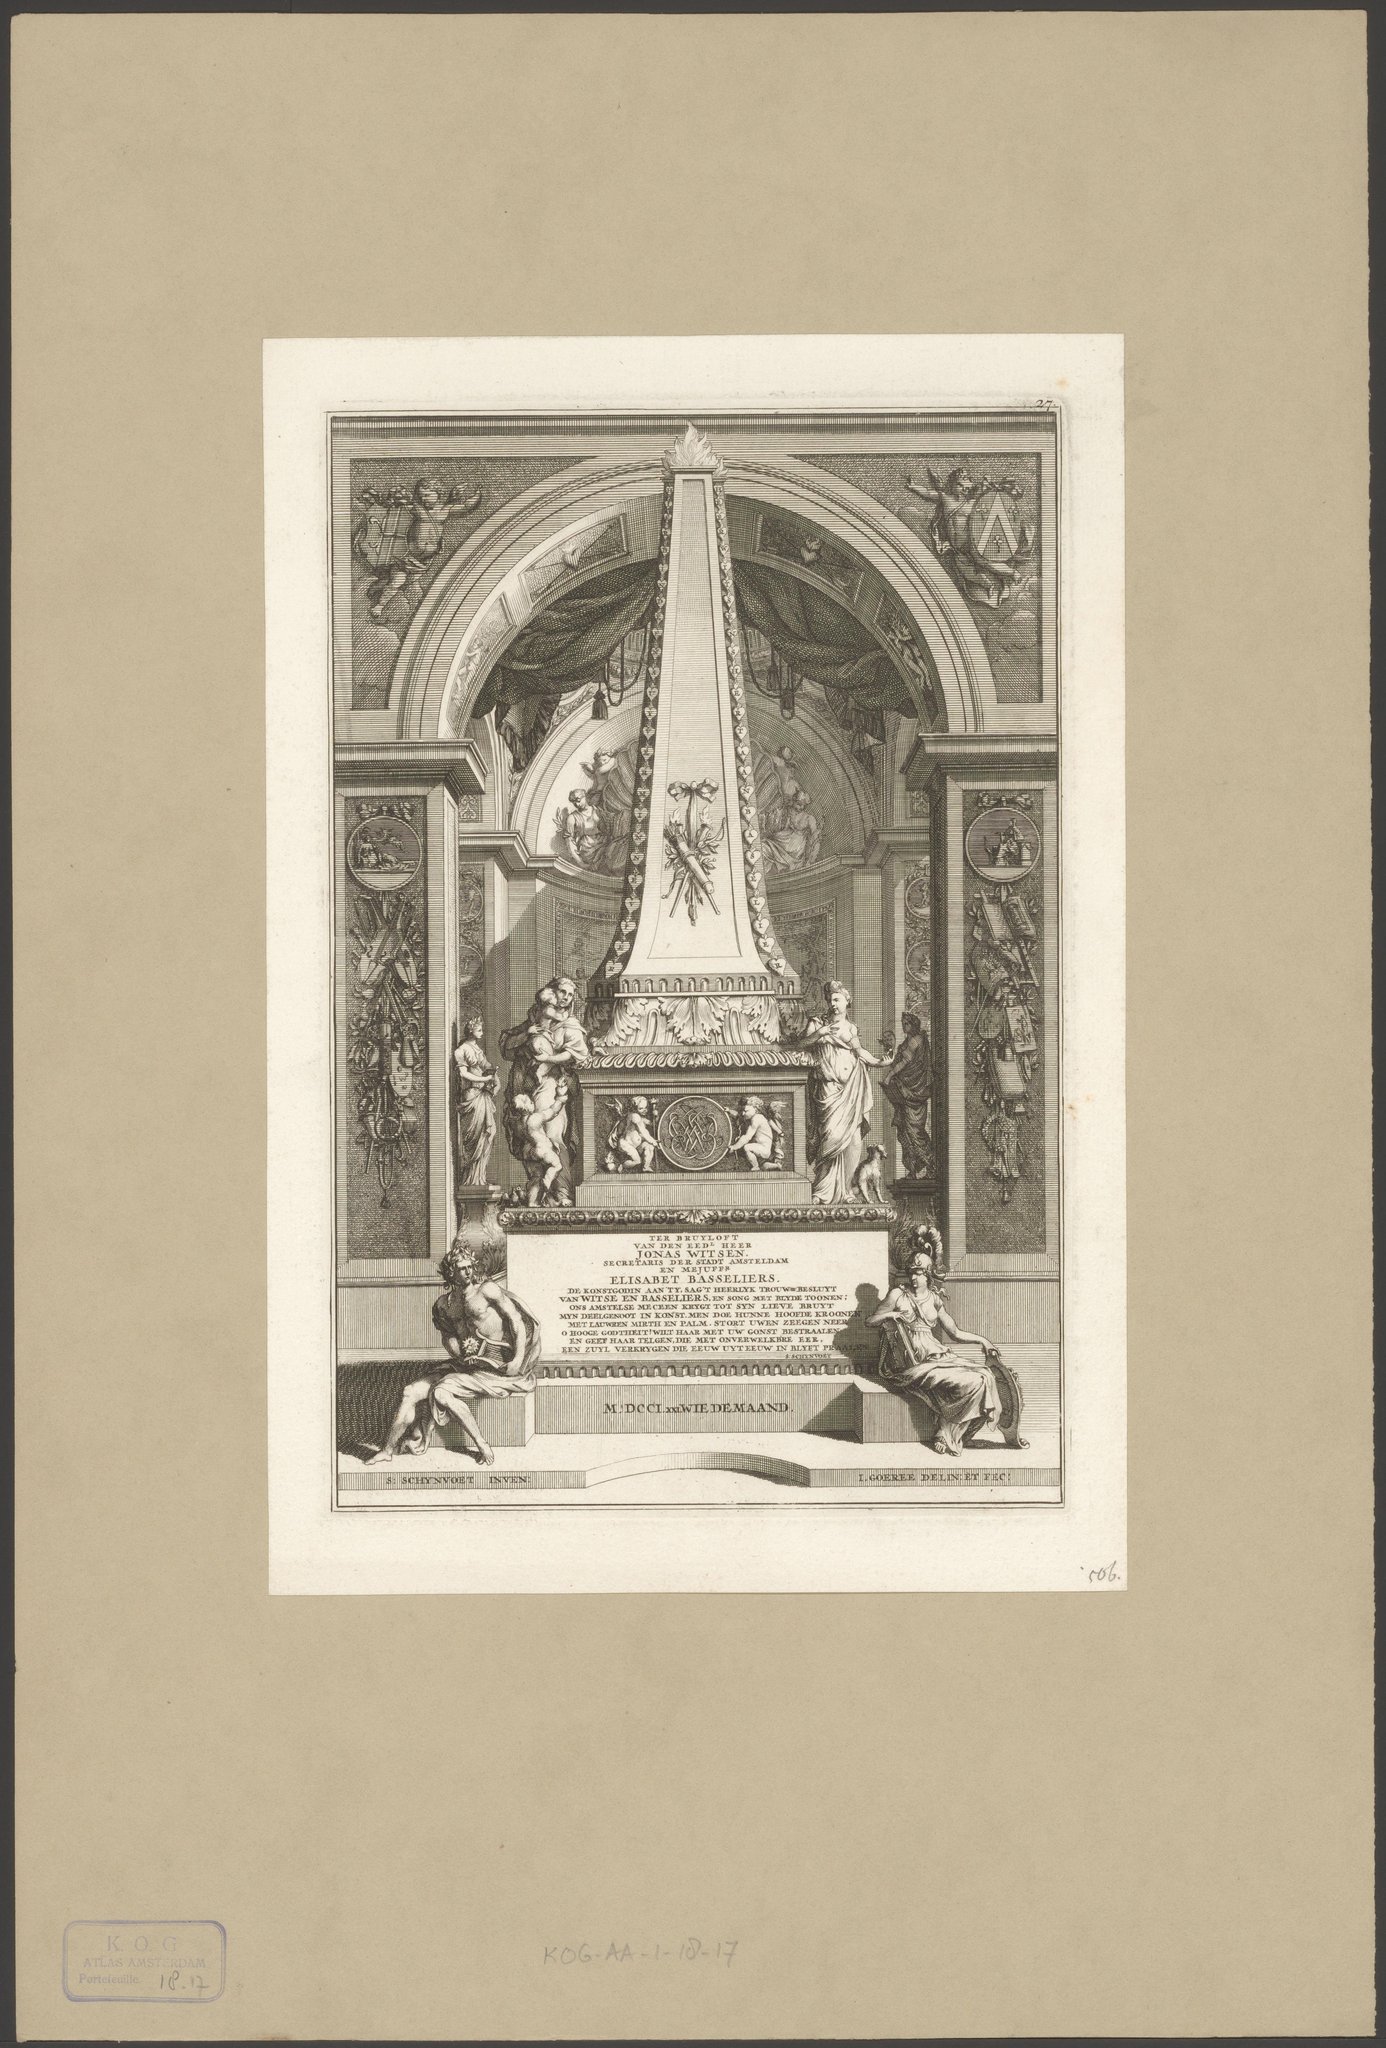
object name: print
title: Monument ter gelegenheid van de bruiloft van Jonas Witsen en Elisabeth Basseliers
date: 1701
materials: paper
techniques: engraving, etching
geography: amsterdam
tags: amsterdam, print maker, mayor, jonas witsen, charity, 'caritas'; 'carità' (ripa) ~ one of the three theological virtues, (story of) apollo (phoebus), (story of) minerva (pallas, athena), mayor, burgomaster, monument, statue, frankness, loyalty; 'lealtà', 'realtà' (ripa), cupids: 'amores', 'amoretti', 'putti', ornamenting, decorating ~ applied arts (+ monumental art)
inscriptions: collector's mark: ‘18.17’ Lugt 1641b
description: Onderwerpsrubriek binnen de Atlas Amsterdam: Herinneringen aan regeringsleden en hunne huisgezinnen [voor 1800]. Genummerd rechtsboven: 27.